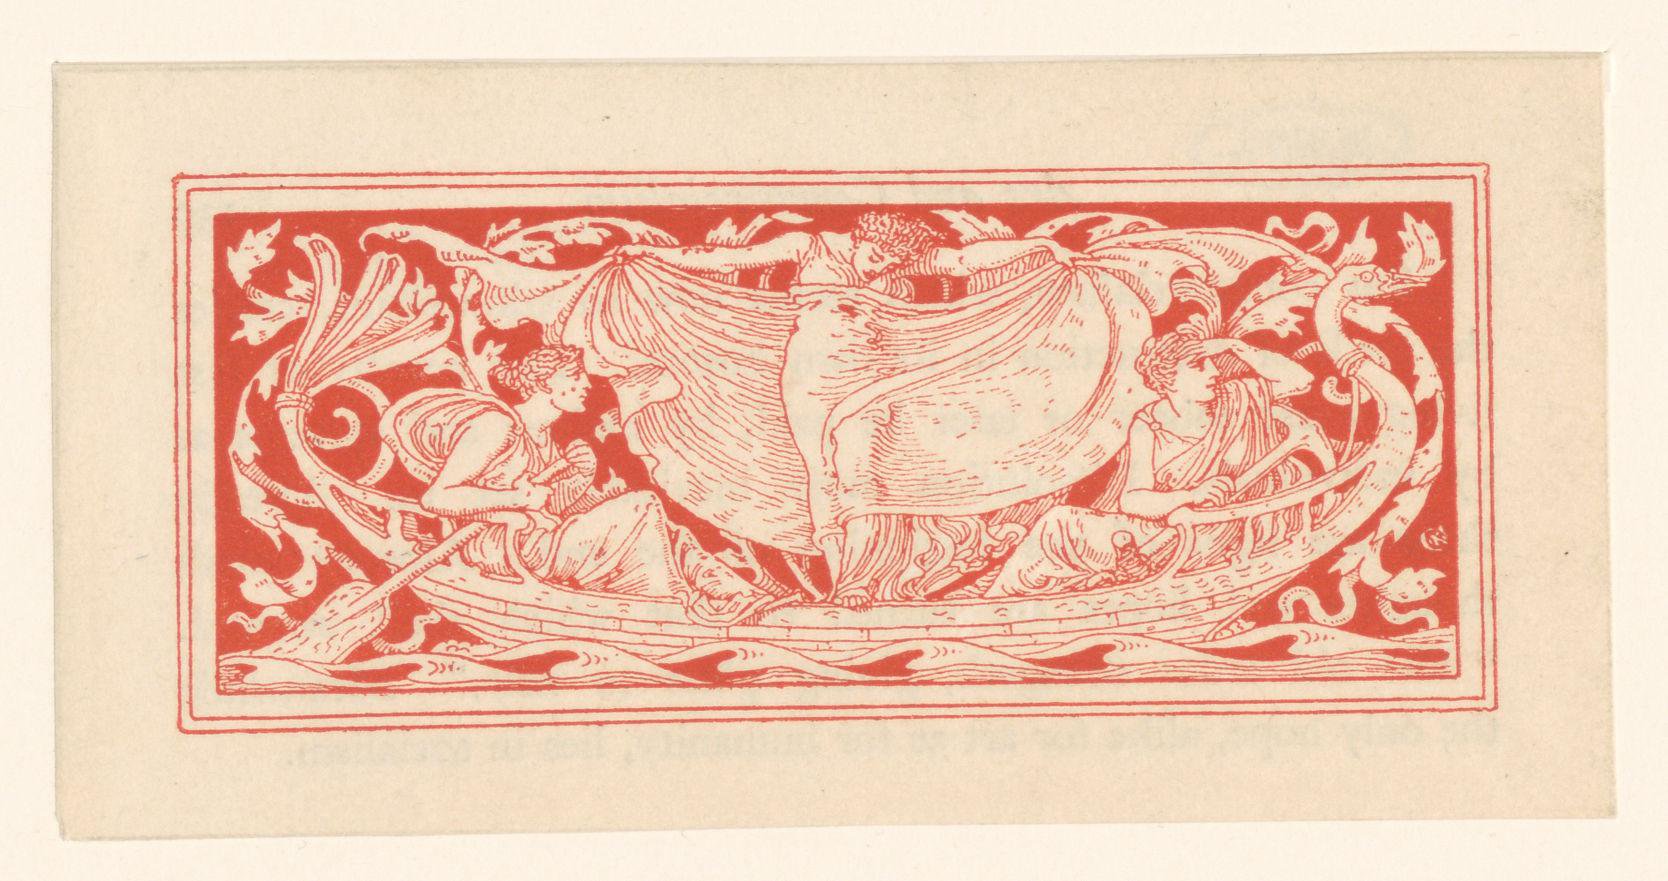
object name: book illustration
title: Drie vrouwen in een roeiboot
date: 1892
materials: paper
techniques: letterpress printing, engraving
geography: edinburgh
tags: rowing-boat, canoe, etc., adult woman (+ three persons)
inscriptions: collector's mark: Lugt 2228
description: Prent uit: Crane, Walter. The claims of decorative art. Londen: Lawrence & Bullen, 1892, p. 139-140.